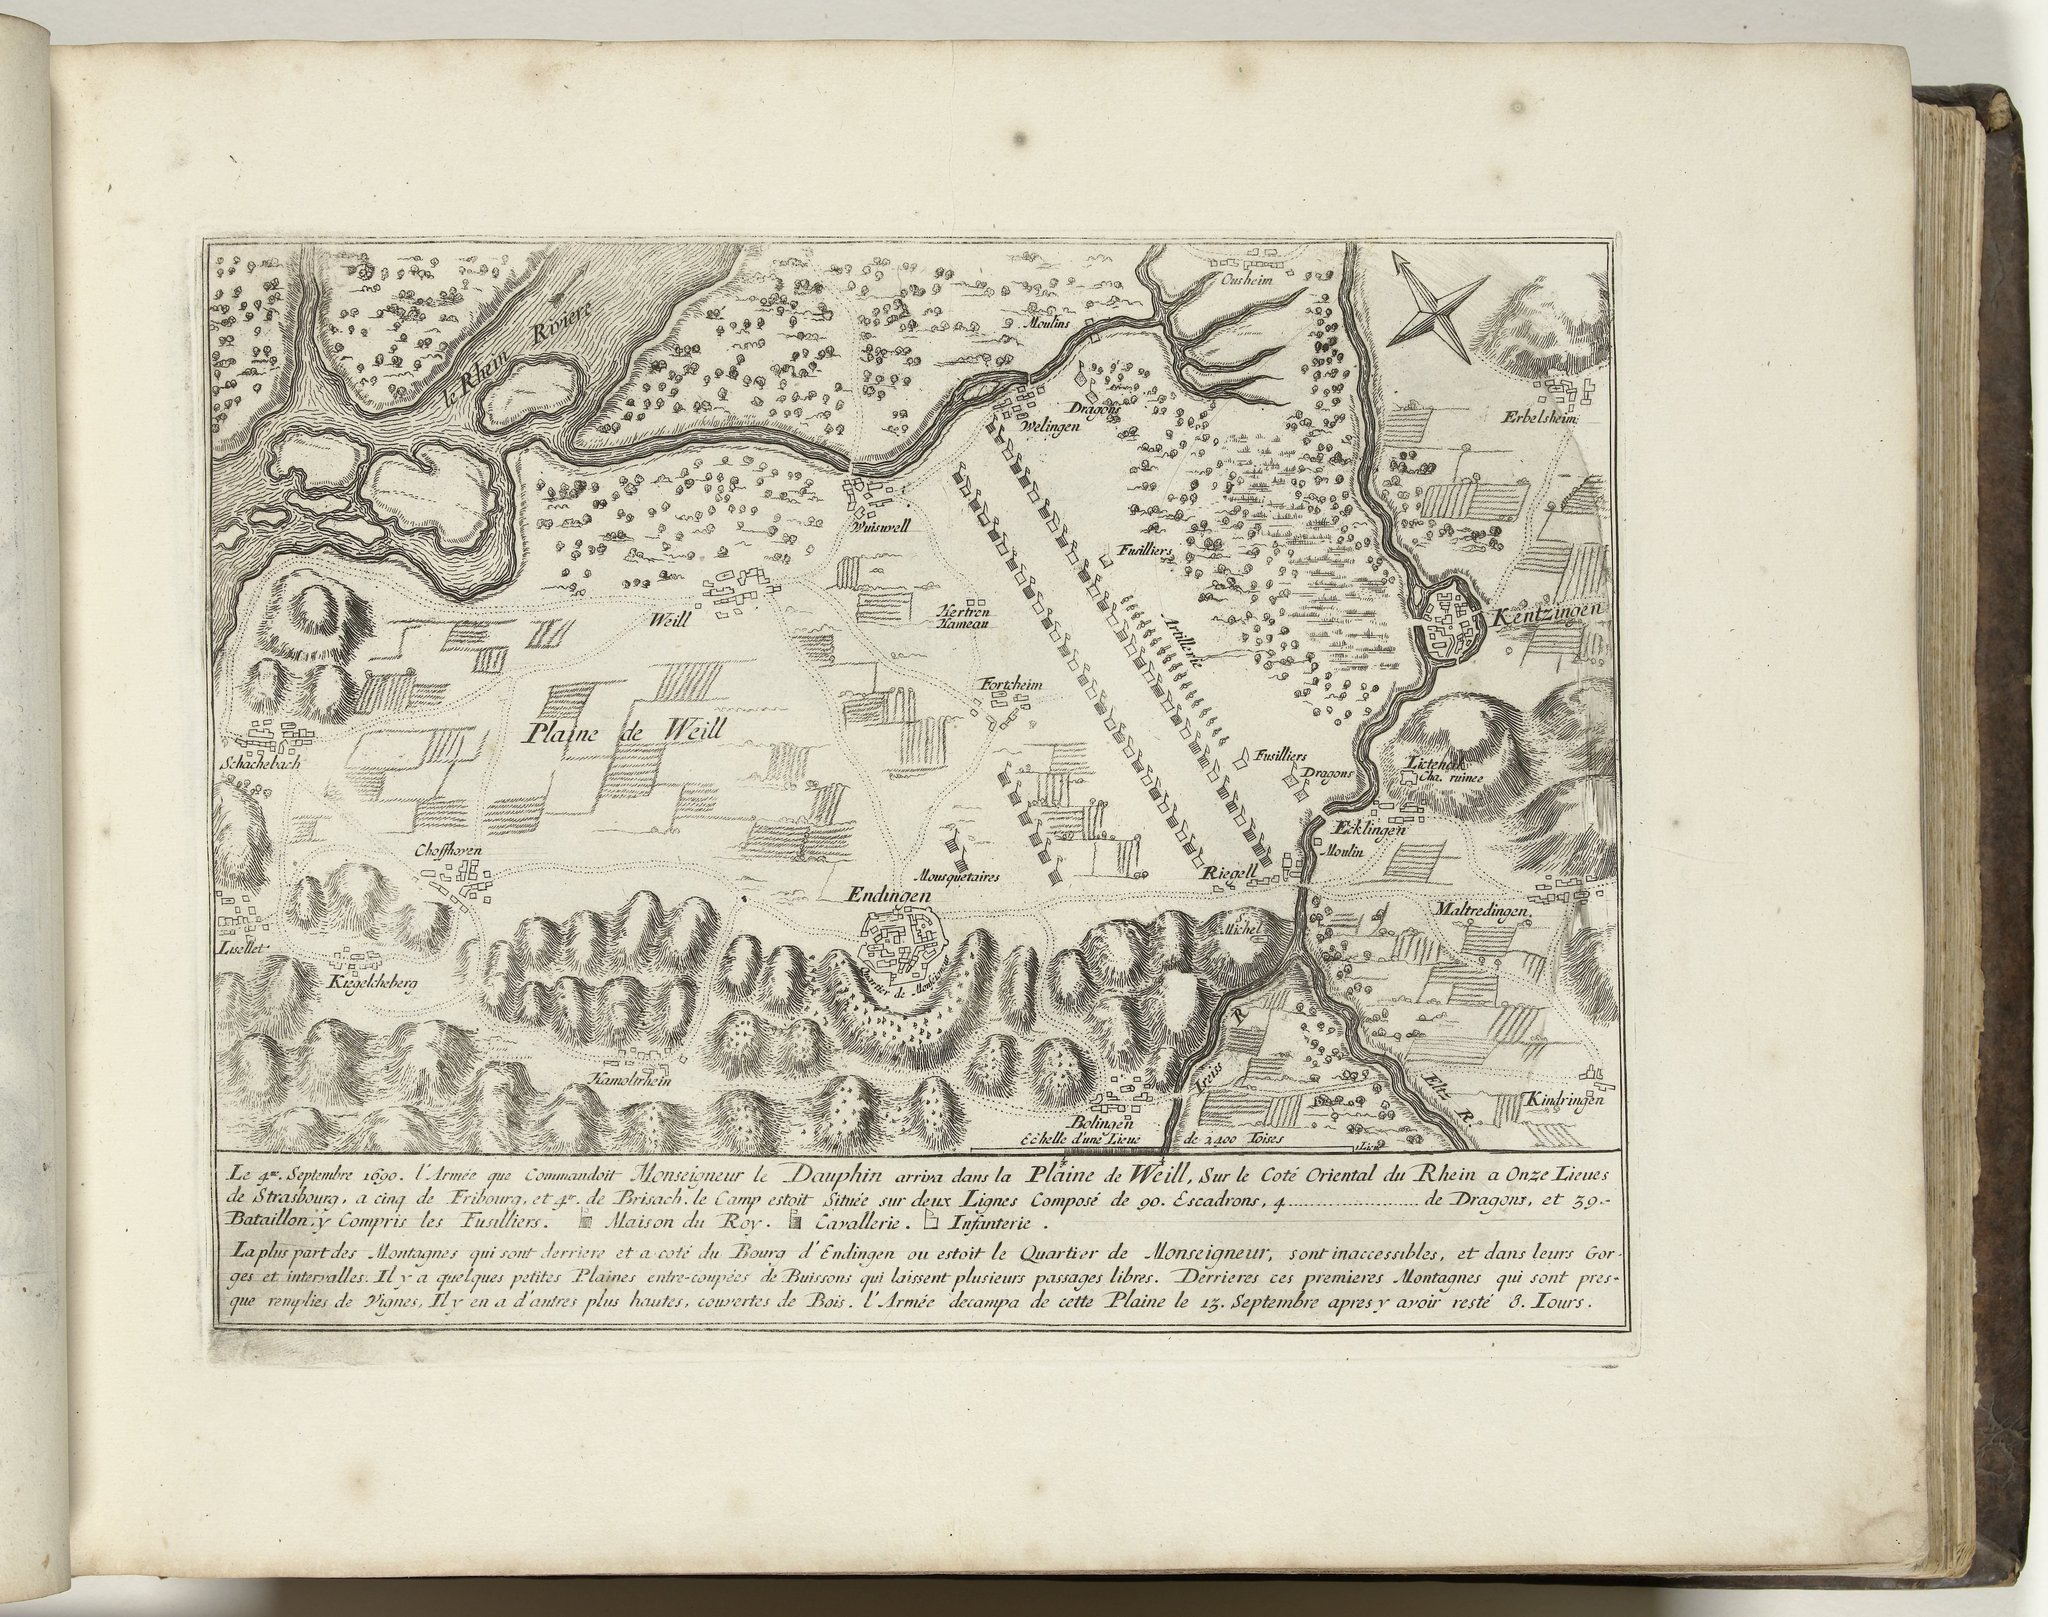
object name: print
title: Les forces de l'Europe, ou description des principales villes, avec leurs fortifications : dessignées par les meilleurs ingenieurs, particulierement celles (...) de la France, dont les plans ont esté levez par M. de Vauban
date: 1693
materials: paper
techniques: etching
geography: paris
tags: maps of separate countries or regions, germany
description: Het Franse leger gekampeerd op de Plaine de Weill bij Endingen langs de Rijn, september 1690. Onderdeel van het tweede deel (1693) van het prentwerk waarin gebundeld zijn de acht delen van Les forces de l'Europe uitgegeven tussen 1693-1697. Het prentwerk bestaat uit 175 platen met plannen (afkomstig van Sébastien Le Prestre, Seigneur de Vauban) van vermaarde sterke steden en vestingen in de Negenjarige Oorlog. Titel in het Frans.